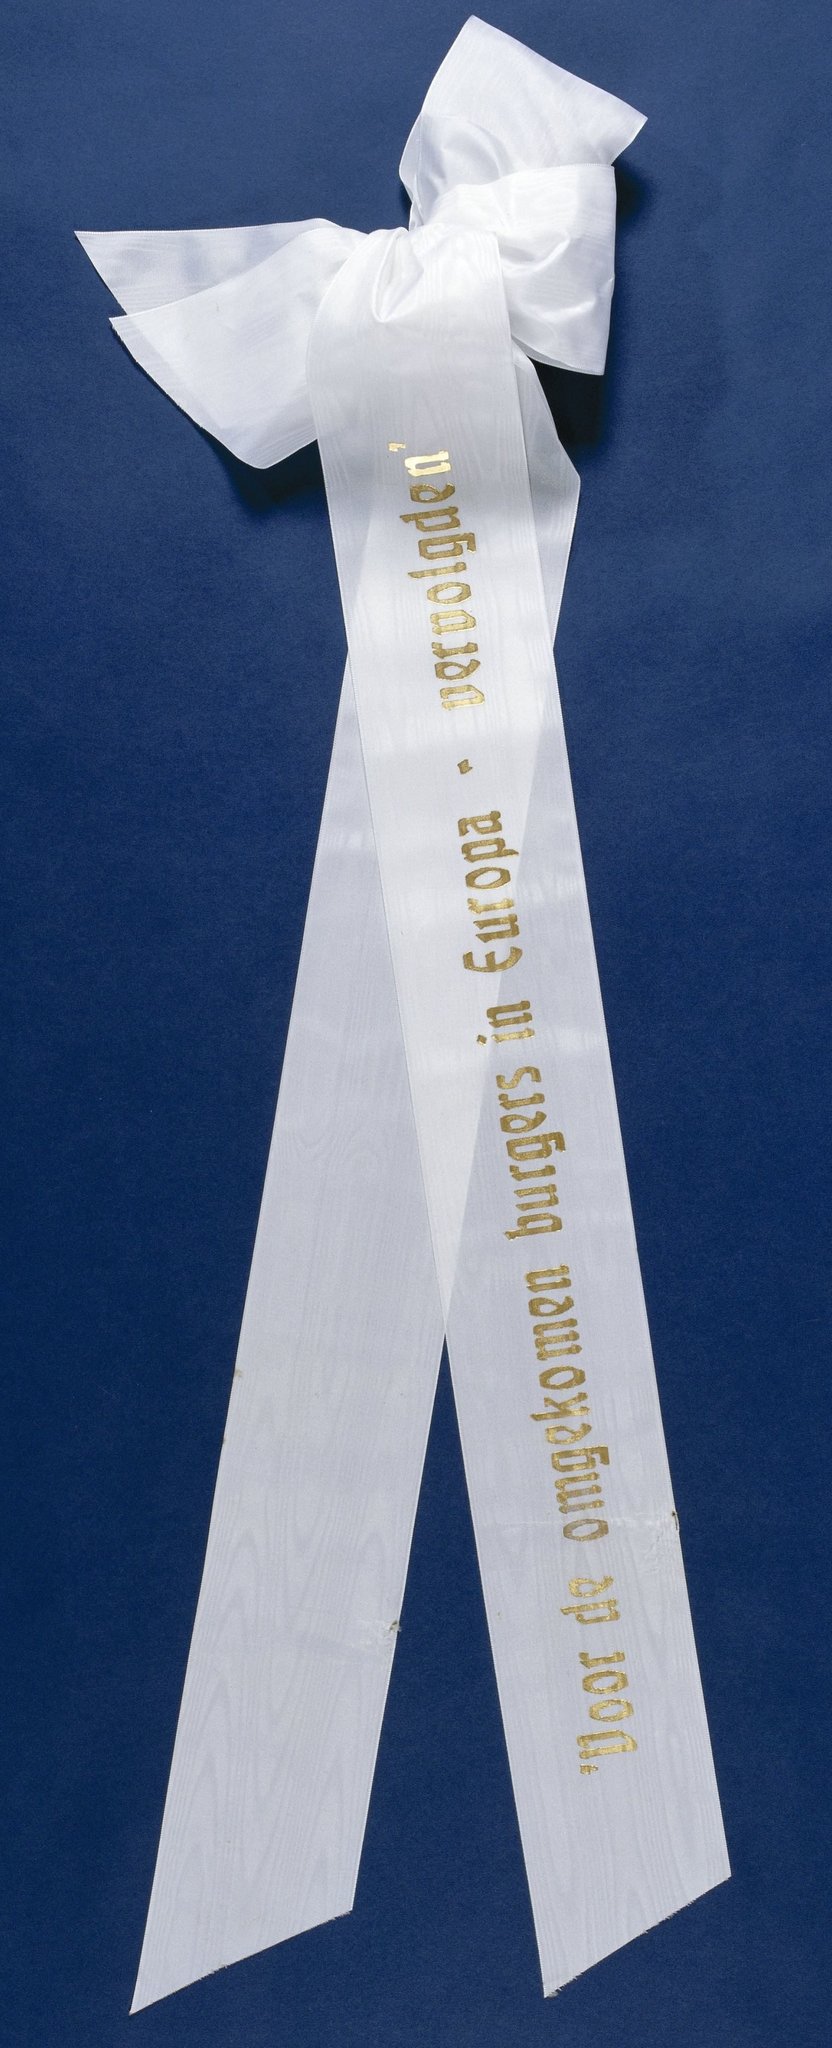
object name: ribbon material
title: Lint 'Voor de omgekomen burgers in Europa - vervolgden'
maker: Anonymous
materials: gold leaf, textile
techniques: printing, weave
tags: amsterdam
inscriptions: inscription: ‘'Voor de omgekomen burgers in Europa - vervolgden'’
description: Twee aan elkaar gebonden witte linten, gelegd op 4 mei 2000 bij het Nationaal Monument op de Dam. Het bovenste lint is v.z.v. een gouden opdruk. Onderste lint is blanco. Linten zijn aan de uiteinden schuin afgeknipt. Aan een zijde tot strik samengebonden met ijzerdraad. IJzerdraad gebogen t.b.v. bevestiging aan krans.